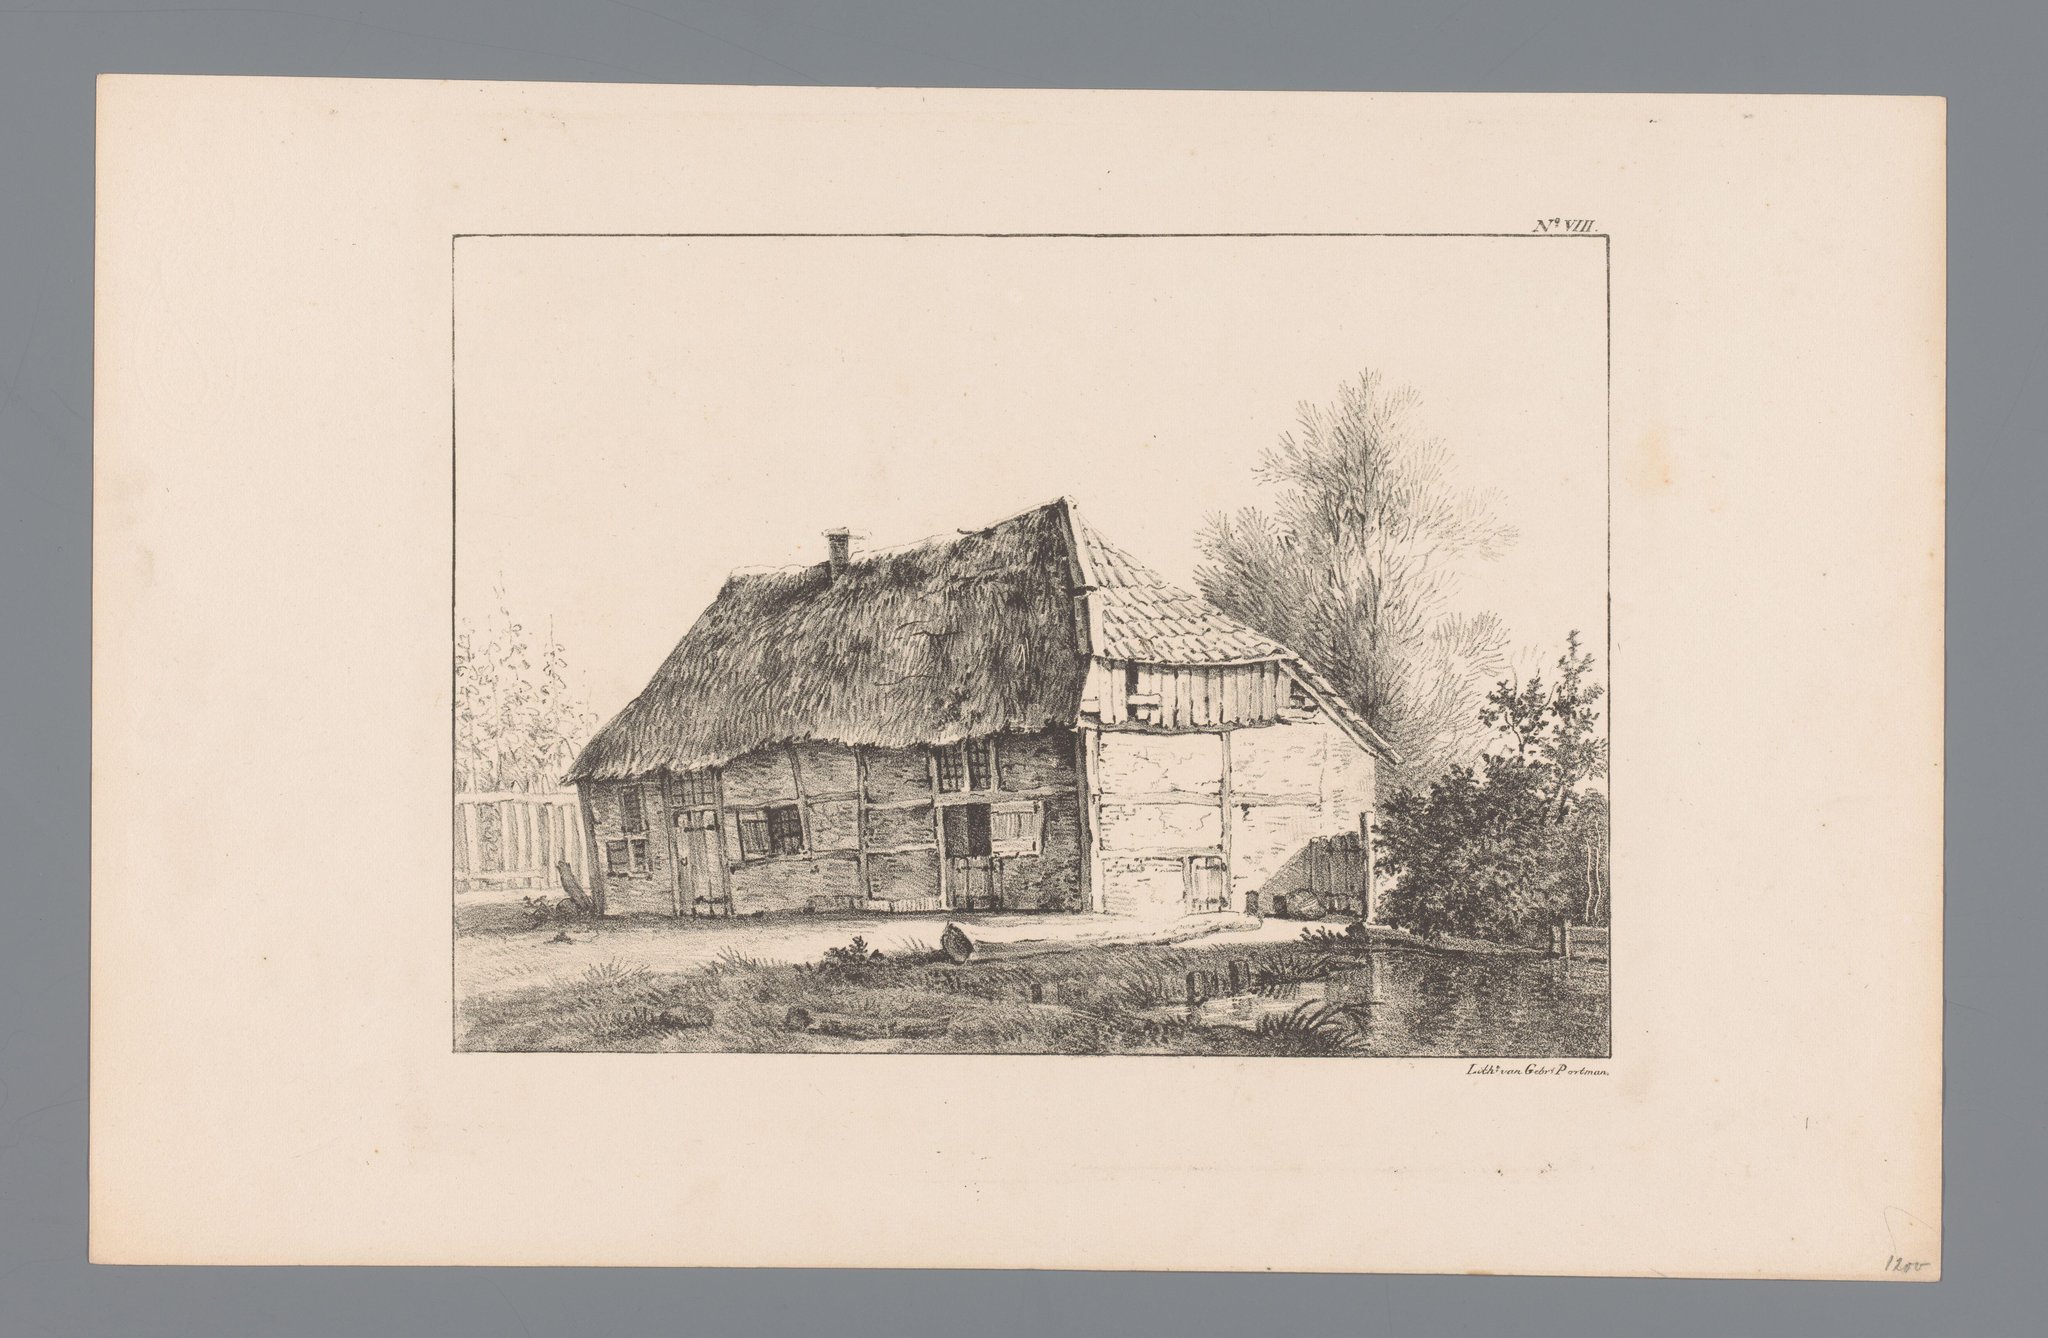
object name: print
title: Boerenwoning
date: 1809-1845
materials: paper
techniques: lithograph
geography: amsterdam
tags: farm or solitary house in landscape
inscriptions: collector's mark: Lugt 2228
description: Boerenwoning met boerendeur waarvan het bovenste deel geopend is. Rechts een plas. Onderdeel van een omslag met een serie van zes landschappen.